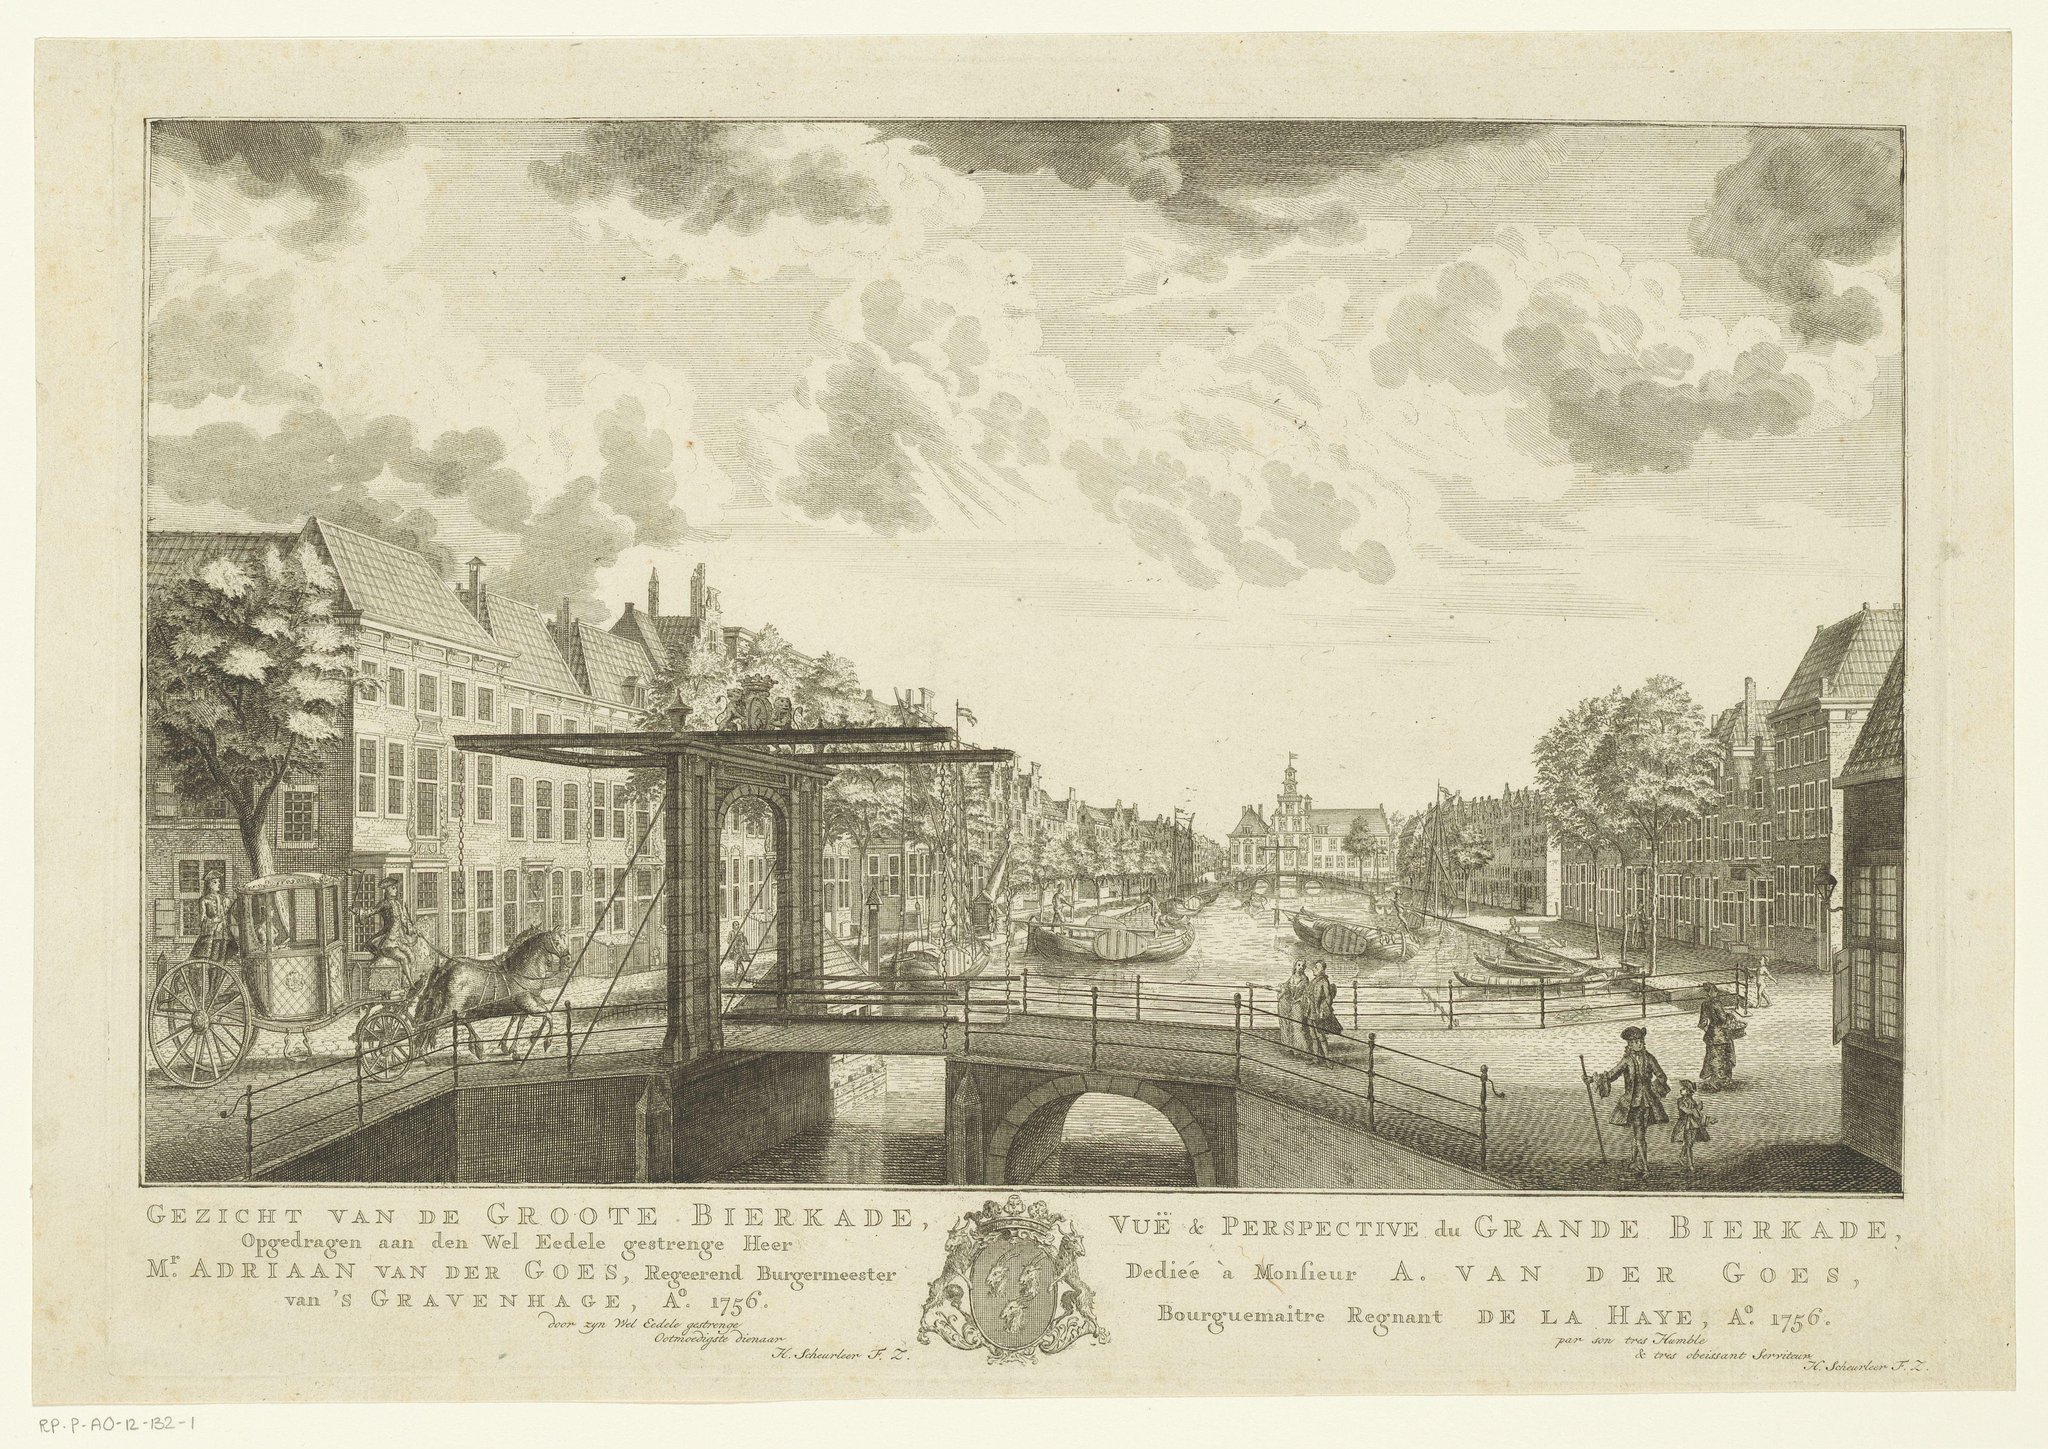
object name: print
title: Gezicht op de Bierkade te Den Haag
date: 1756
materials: paper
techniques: engraving, etching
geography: the hague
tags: orphanage, bridge in city across river, canal, etc., armorial bearing, heraldry, street (+ city(-scape) with figures, staffage), the hague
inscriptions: collector's mark: Lugt 195, collector's mark: Lugt 2228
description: Gezicht op de Bierkade te Den Haag. Op de voorgrond de Wagenbrug en op de achtergrond het Diaconie Oude Vrouwen- en Kinderhuis. Onder de voorstelling de titel en opdracht in het Nederlands en Frans, met in het midden het familiewapen van de Haagse burgemeester Adriaan van der Goes. Prent uit een serie van achttien gezichten in en om Den Haag.